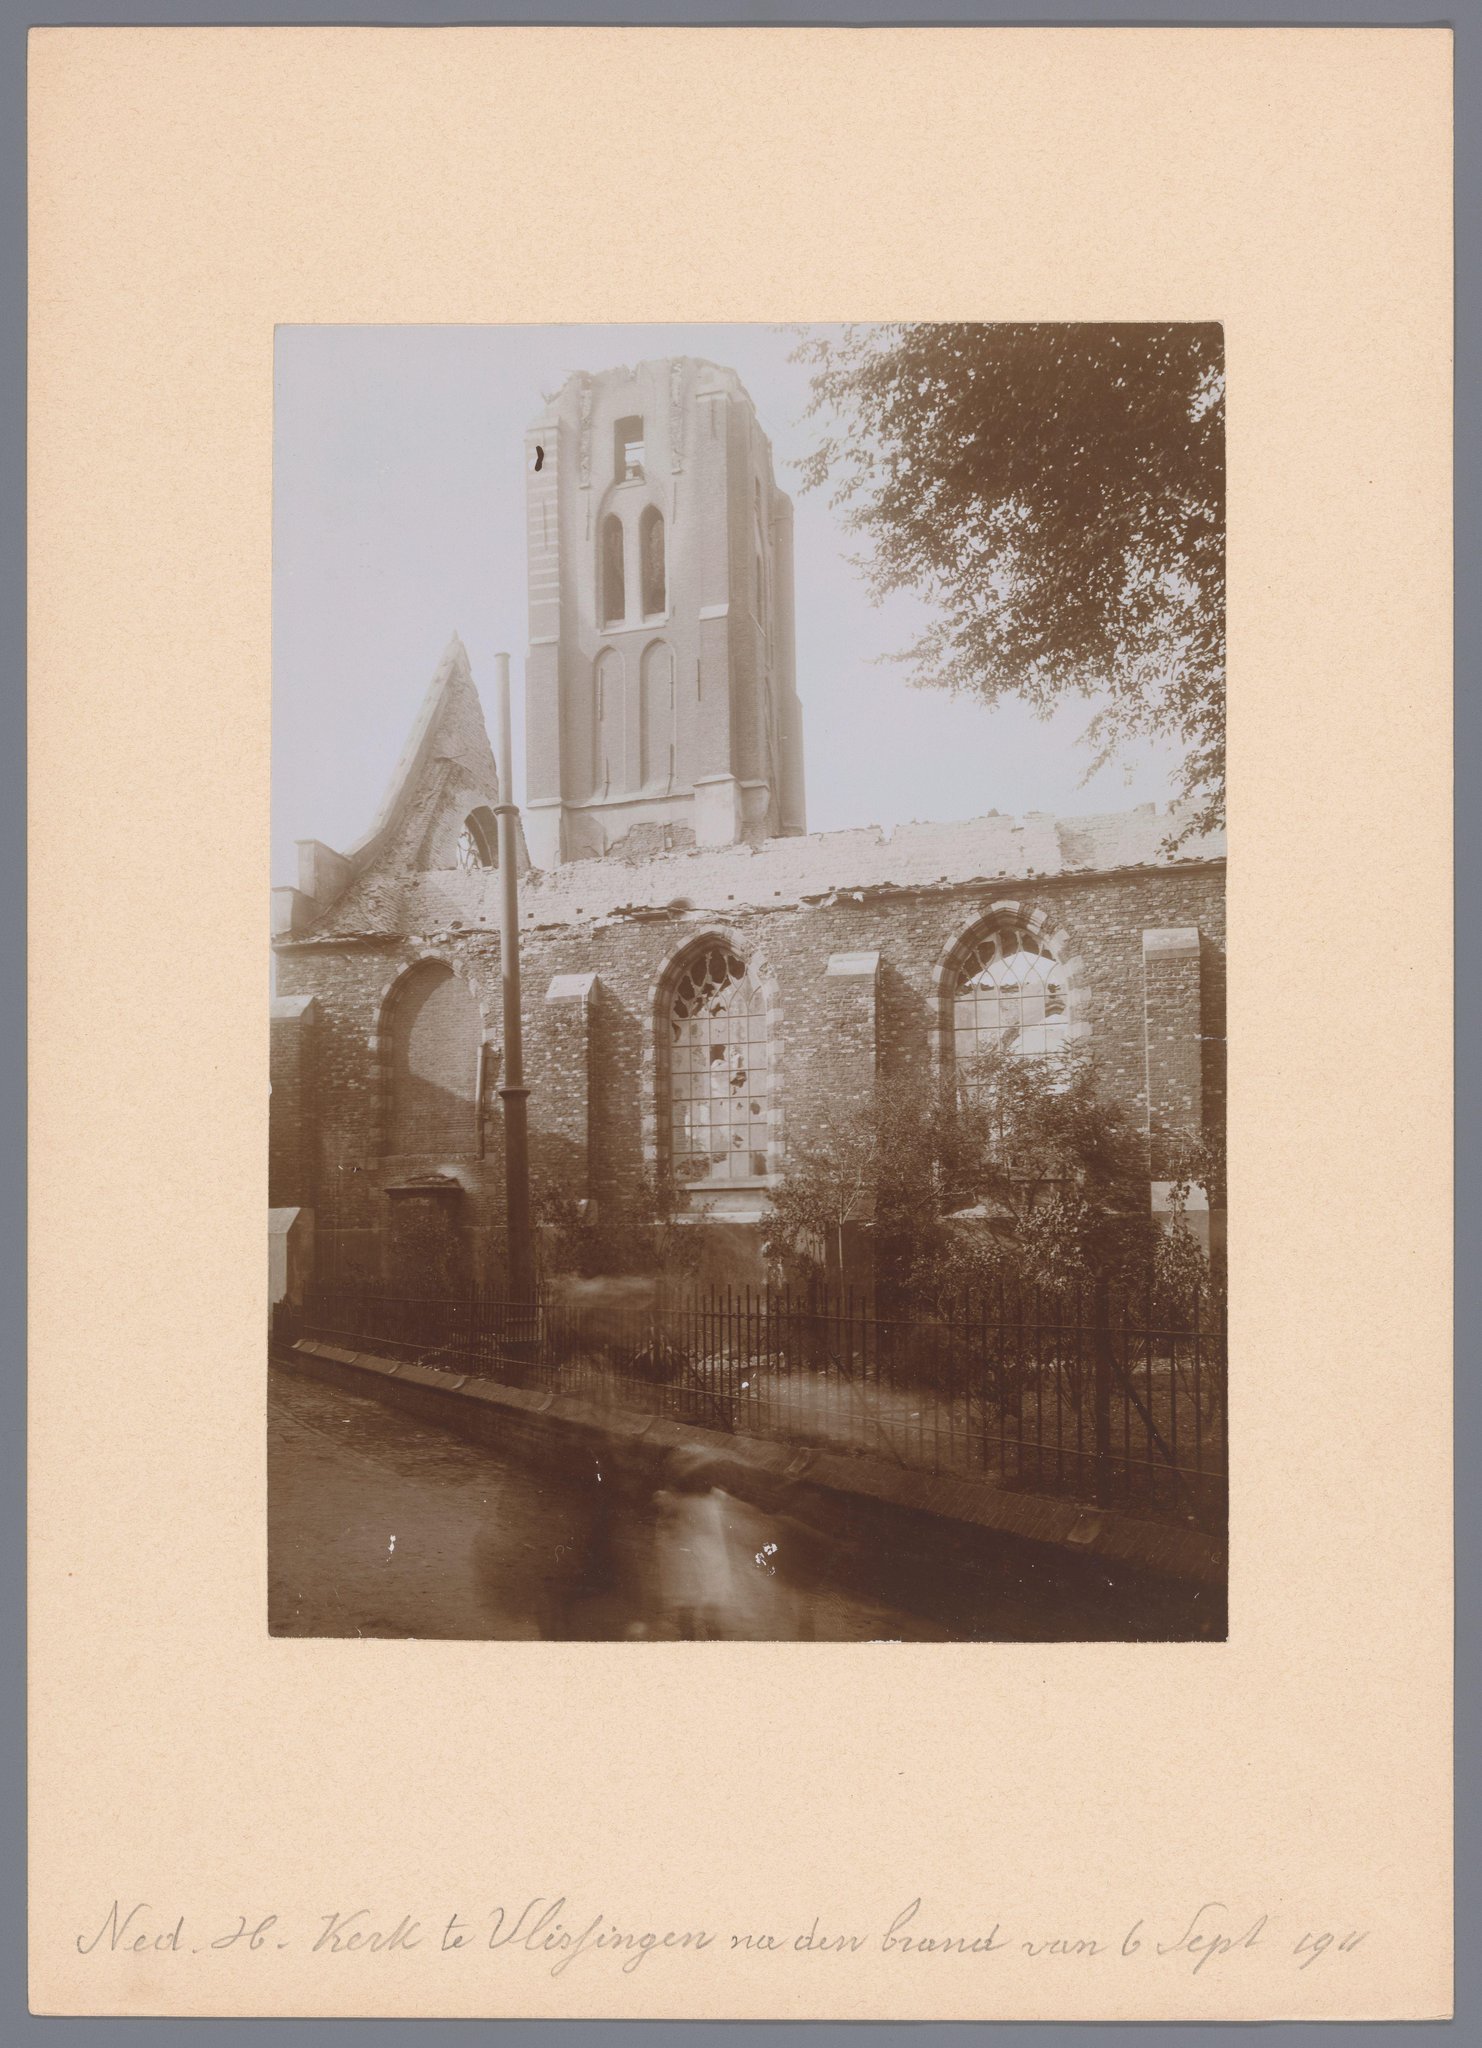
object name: photograph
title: Gezicht op de Hervormde Kerk te Vlissingen na de brand in 1911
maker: anoniem (monumentenzorg)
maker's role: fotograaf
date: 1911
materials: cardboard, photographic support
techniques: collodion silver print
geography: flushing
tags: church (exterior), flushing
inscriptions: annotation: ‘Ned. H. kerk te Vlissingen na den brand van 6 sept. 1911’